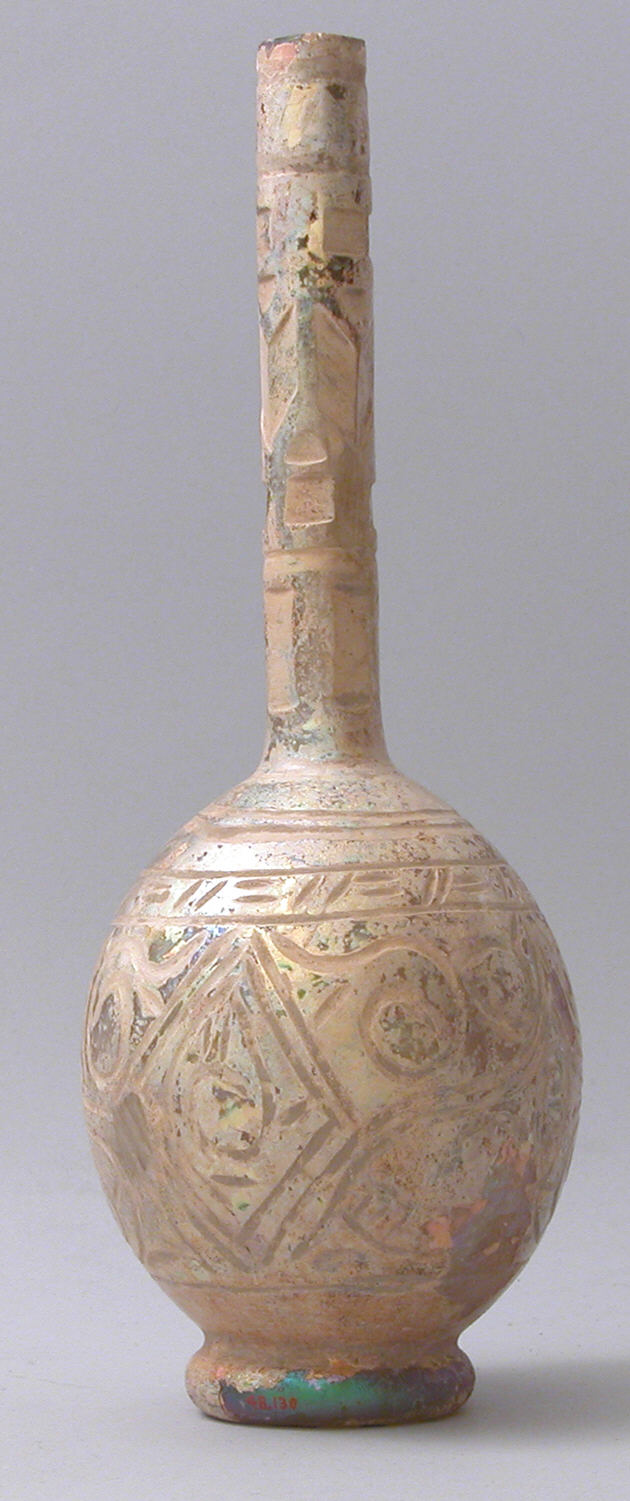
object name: bottle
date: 801-1000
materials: glass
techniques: glassblowing, cutting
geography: iran